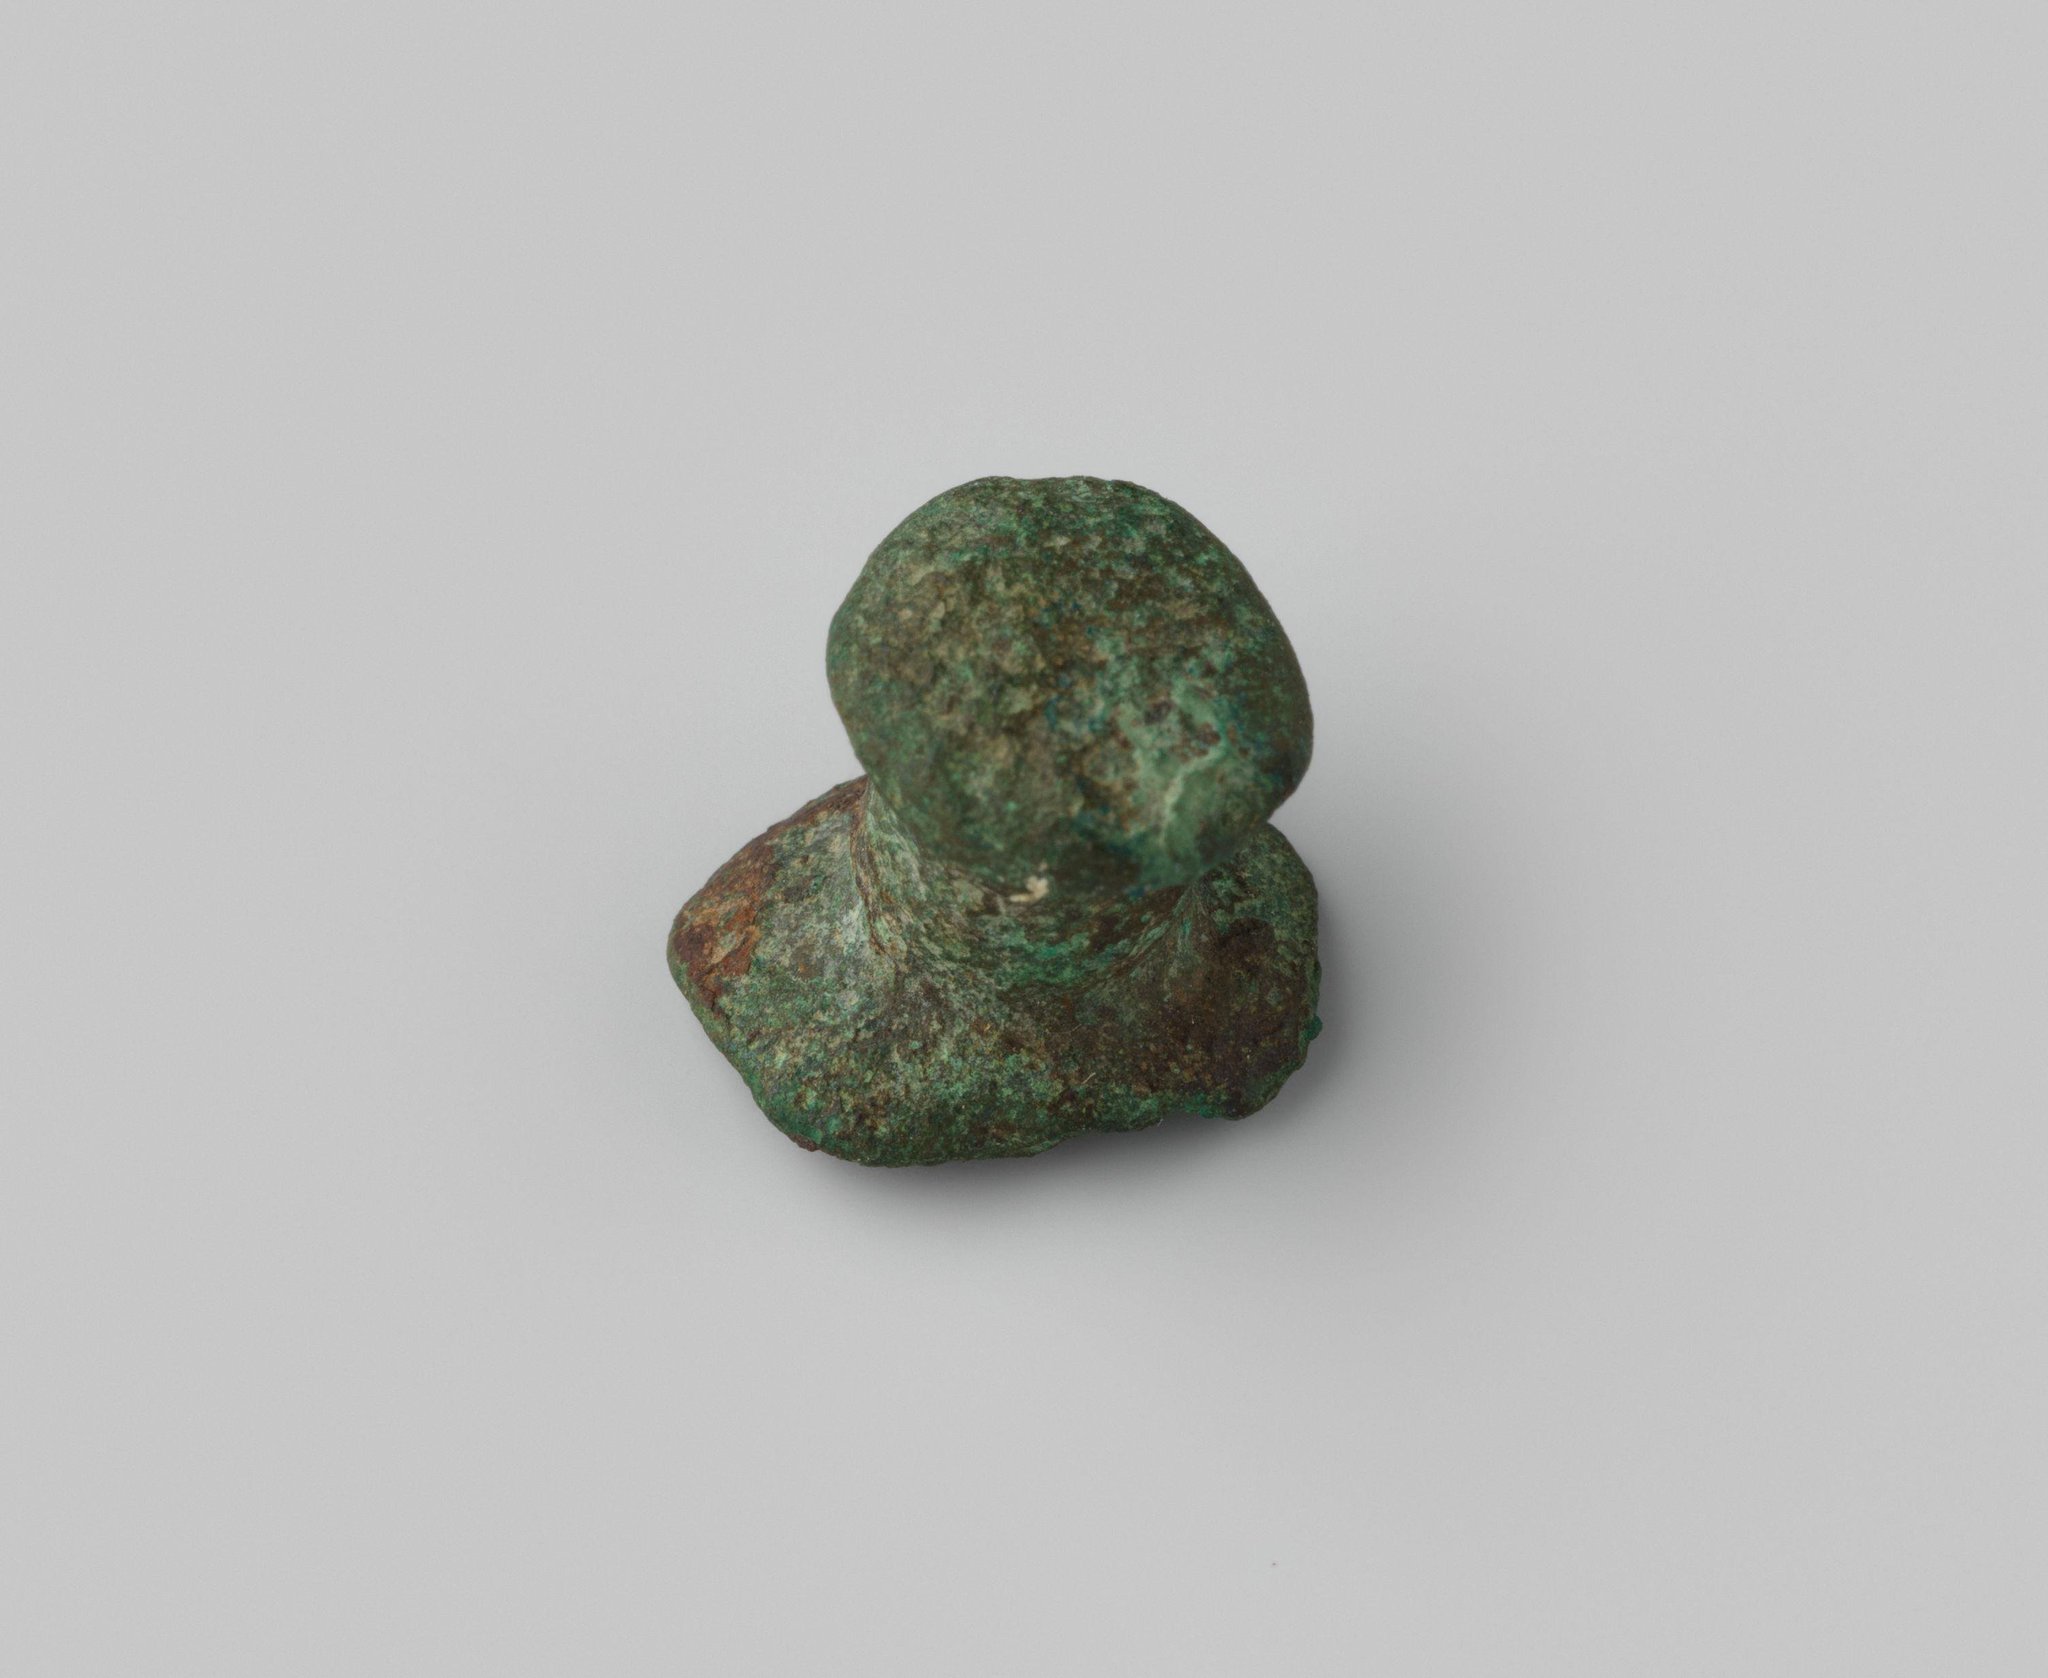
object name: rivet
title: Klinknagel afkomstig uit het wrak van de Oost-Indiëvaarder Hollandia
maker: Anonymous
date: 1700-1743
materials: copper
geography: netherlands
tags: verenigde oostindische compagnie, hollandia (schip)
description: Rivets; eroded, shaft circular in section, flanged base, small circular head.